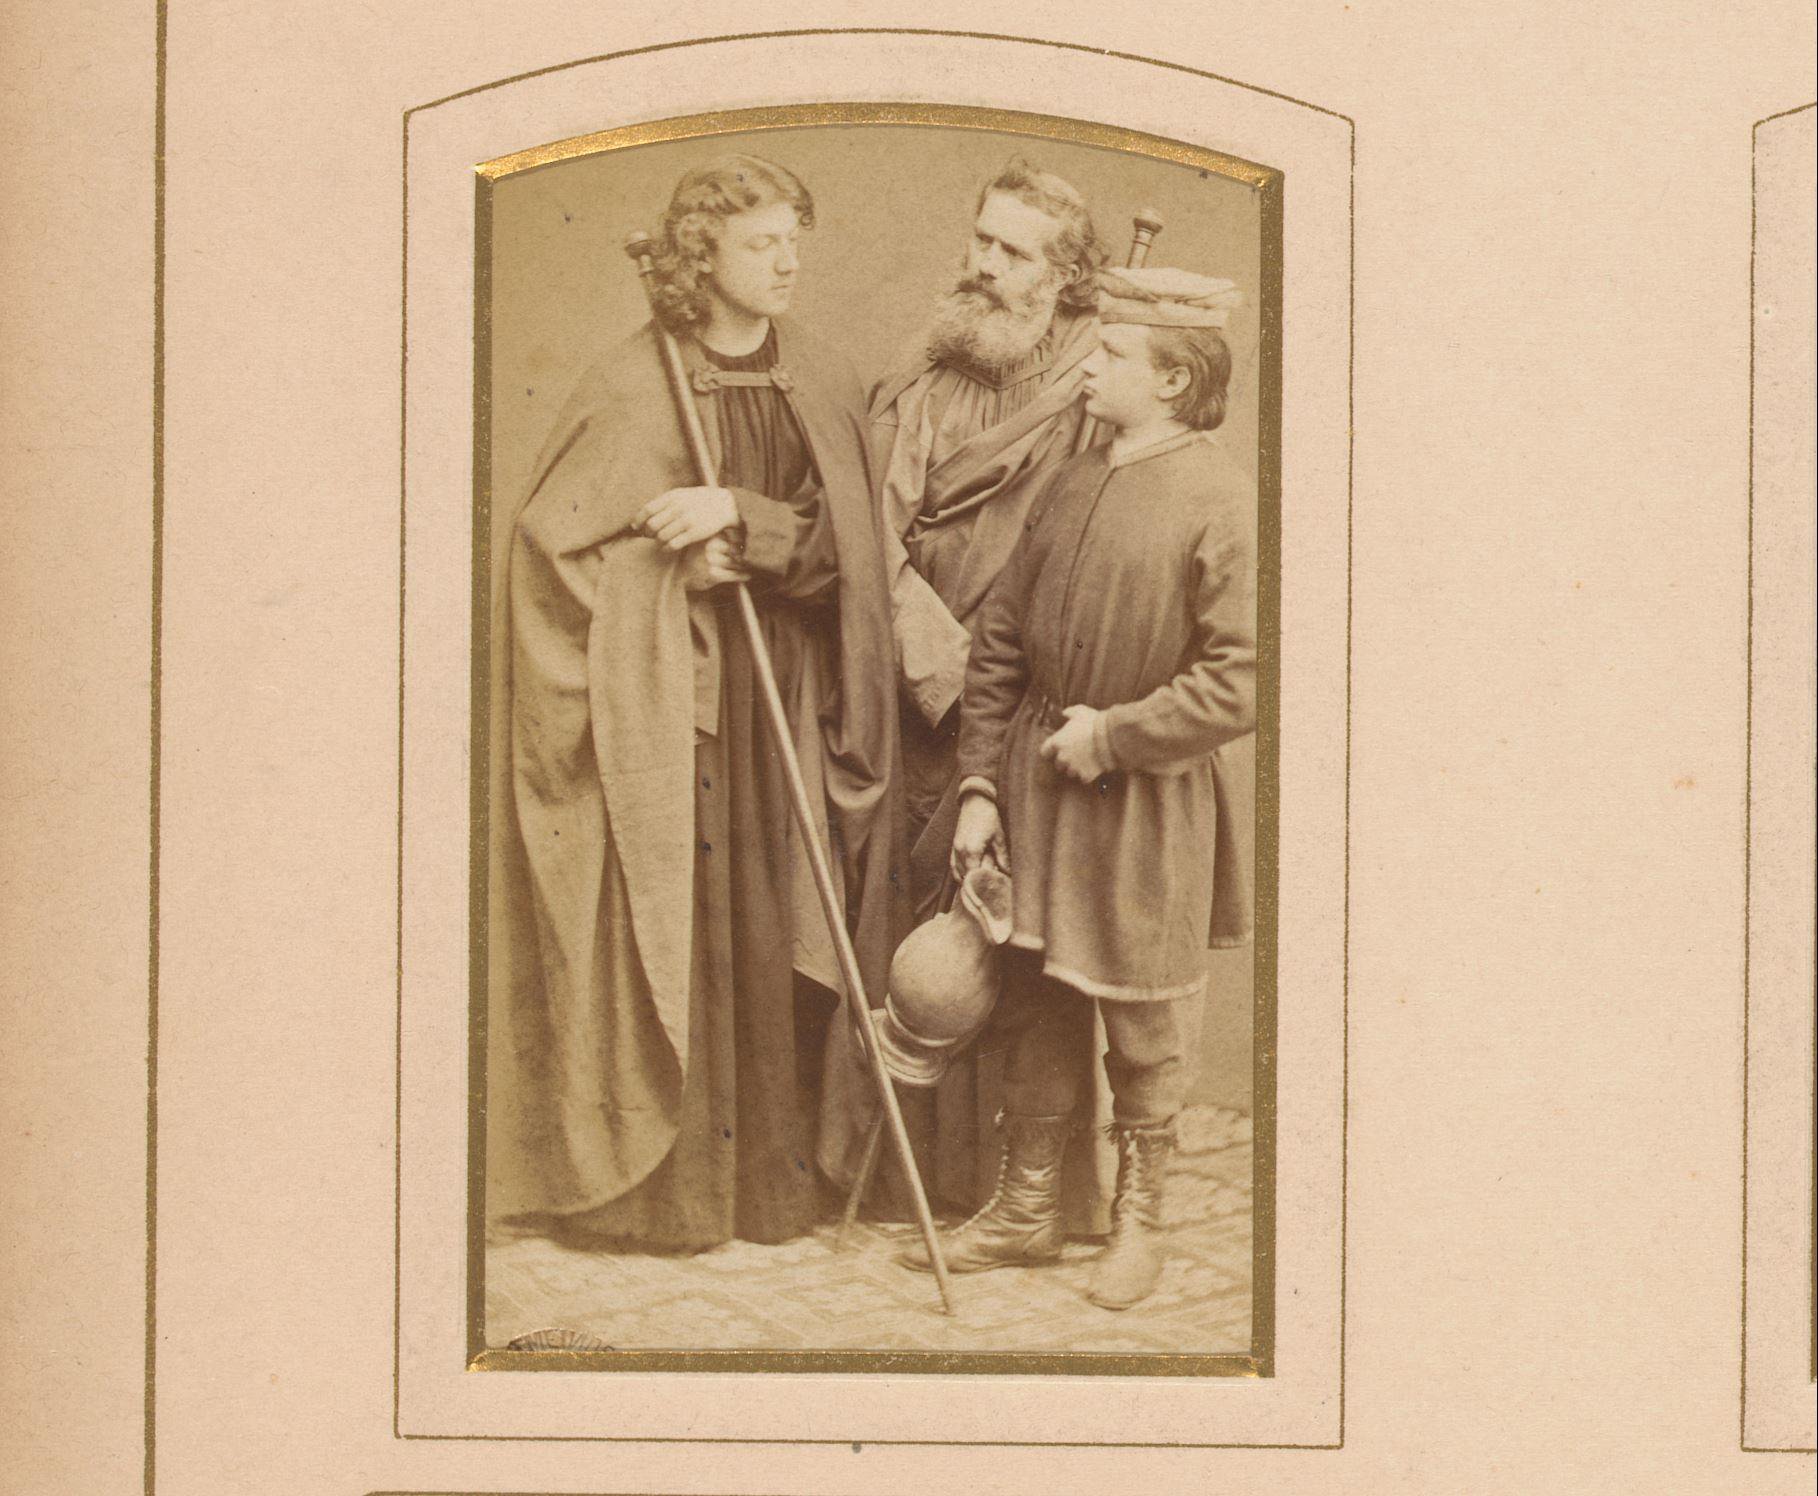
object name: album leaf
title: Scène uit het Passiespel in Oberammergau in 1870, afgebeeld Petrus, Johannes en een jongen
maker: f. steigenberger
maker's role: fotograaf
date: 1870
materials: cardboard, photographic support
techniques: albumen print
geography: oberammergau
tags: the apostle john the evangelist; possible attributes: book, cauldron, chalice with snake, eagle, palm, scroll, theatre, theatrical performance, the apostle peter, first bishop of rome; possible attributes: book, cock, (upturned) cross, (triple) crozier, fish, key, scroll, ship, tiara, passion of christ, oberammergau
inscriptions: collector's mark: ‘GEMEINDE/ OBERAMMERGAU’, inscription: ‘F. Steigenberger/ PHOTOGRAPHISCH-ARTIST-ETABLISSEMENT./ STEREOSCOPIE ETC./ WEILHEIM OBERBAYERN./ VERVIELFÄLTIGUNG JEDER ART VORBEHALTEN.’, inscription: ‘Deponirt./ Passionsspiel/ Oberammergau 1870./ Petrus und Johannes bestellen das Abendmahl.’